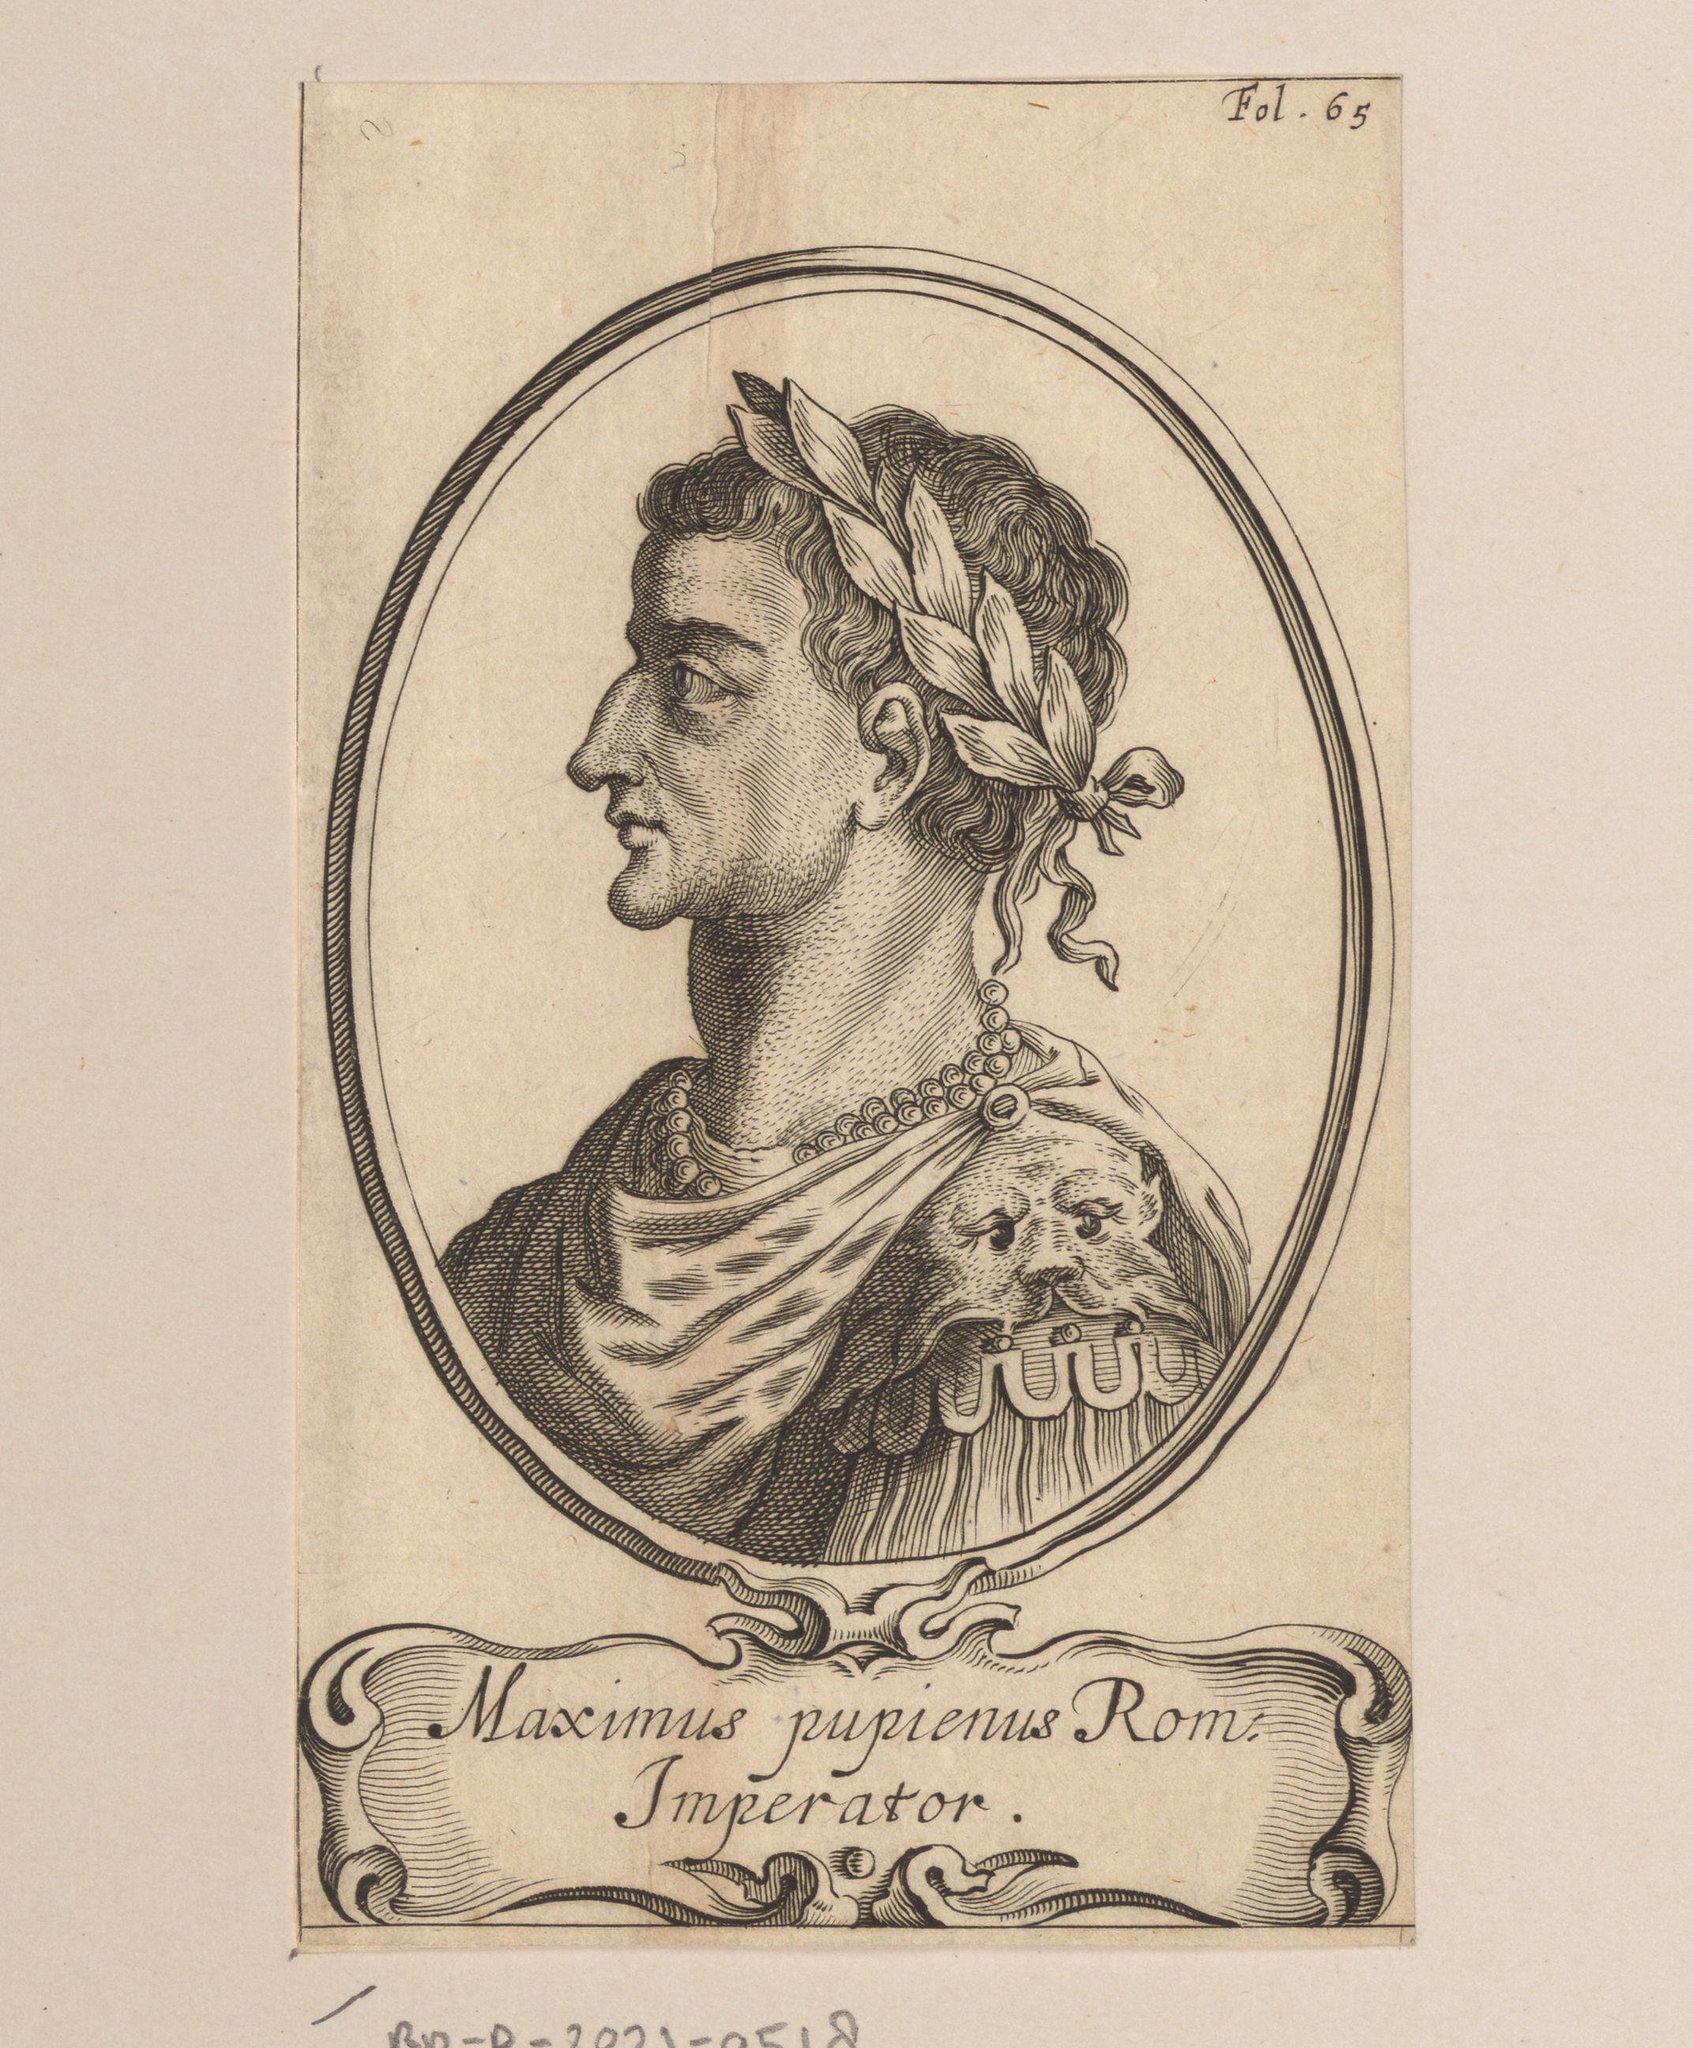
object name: print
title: Portret van onderkeizer Maximus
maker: Anonymous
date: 1656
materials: paper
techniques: engraving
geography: northern netherlands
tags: ornament ~ medallion, historical persons, emperor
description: Prent waarschijnlijk uit: Bos, Lambert van den. Het konincklyk treur-toonneel, ofte op- en ondergangh der keyseren (...). Dordrecht: Jacobus Savry, 1656, p. 65.